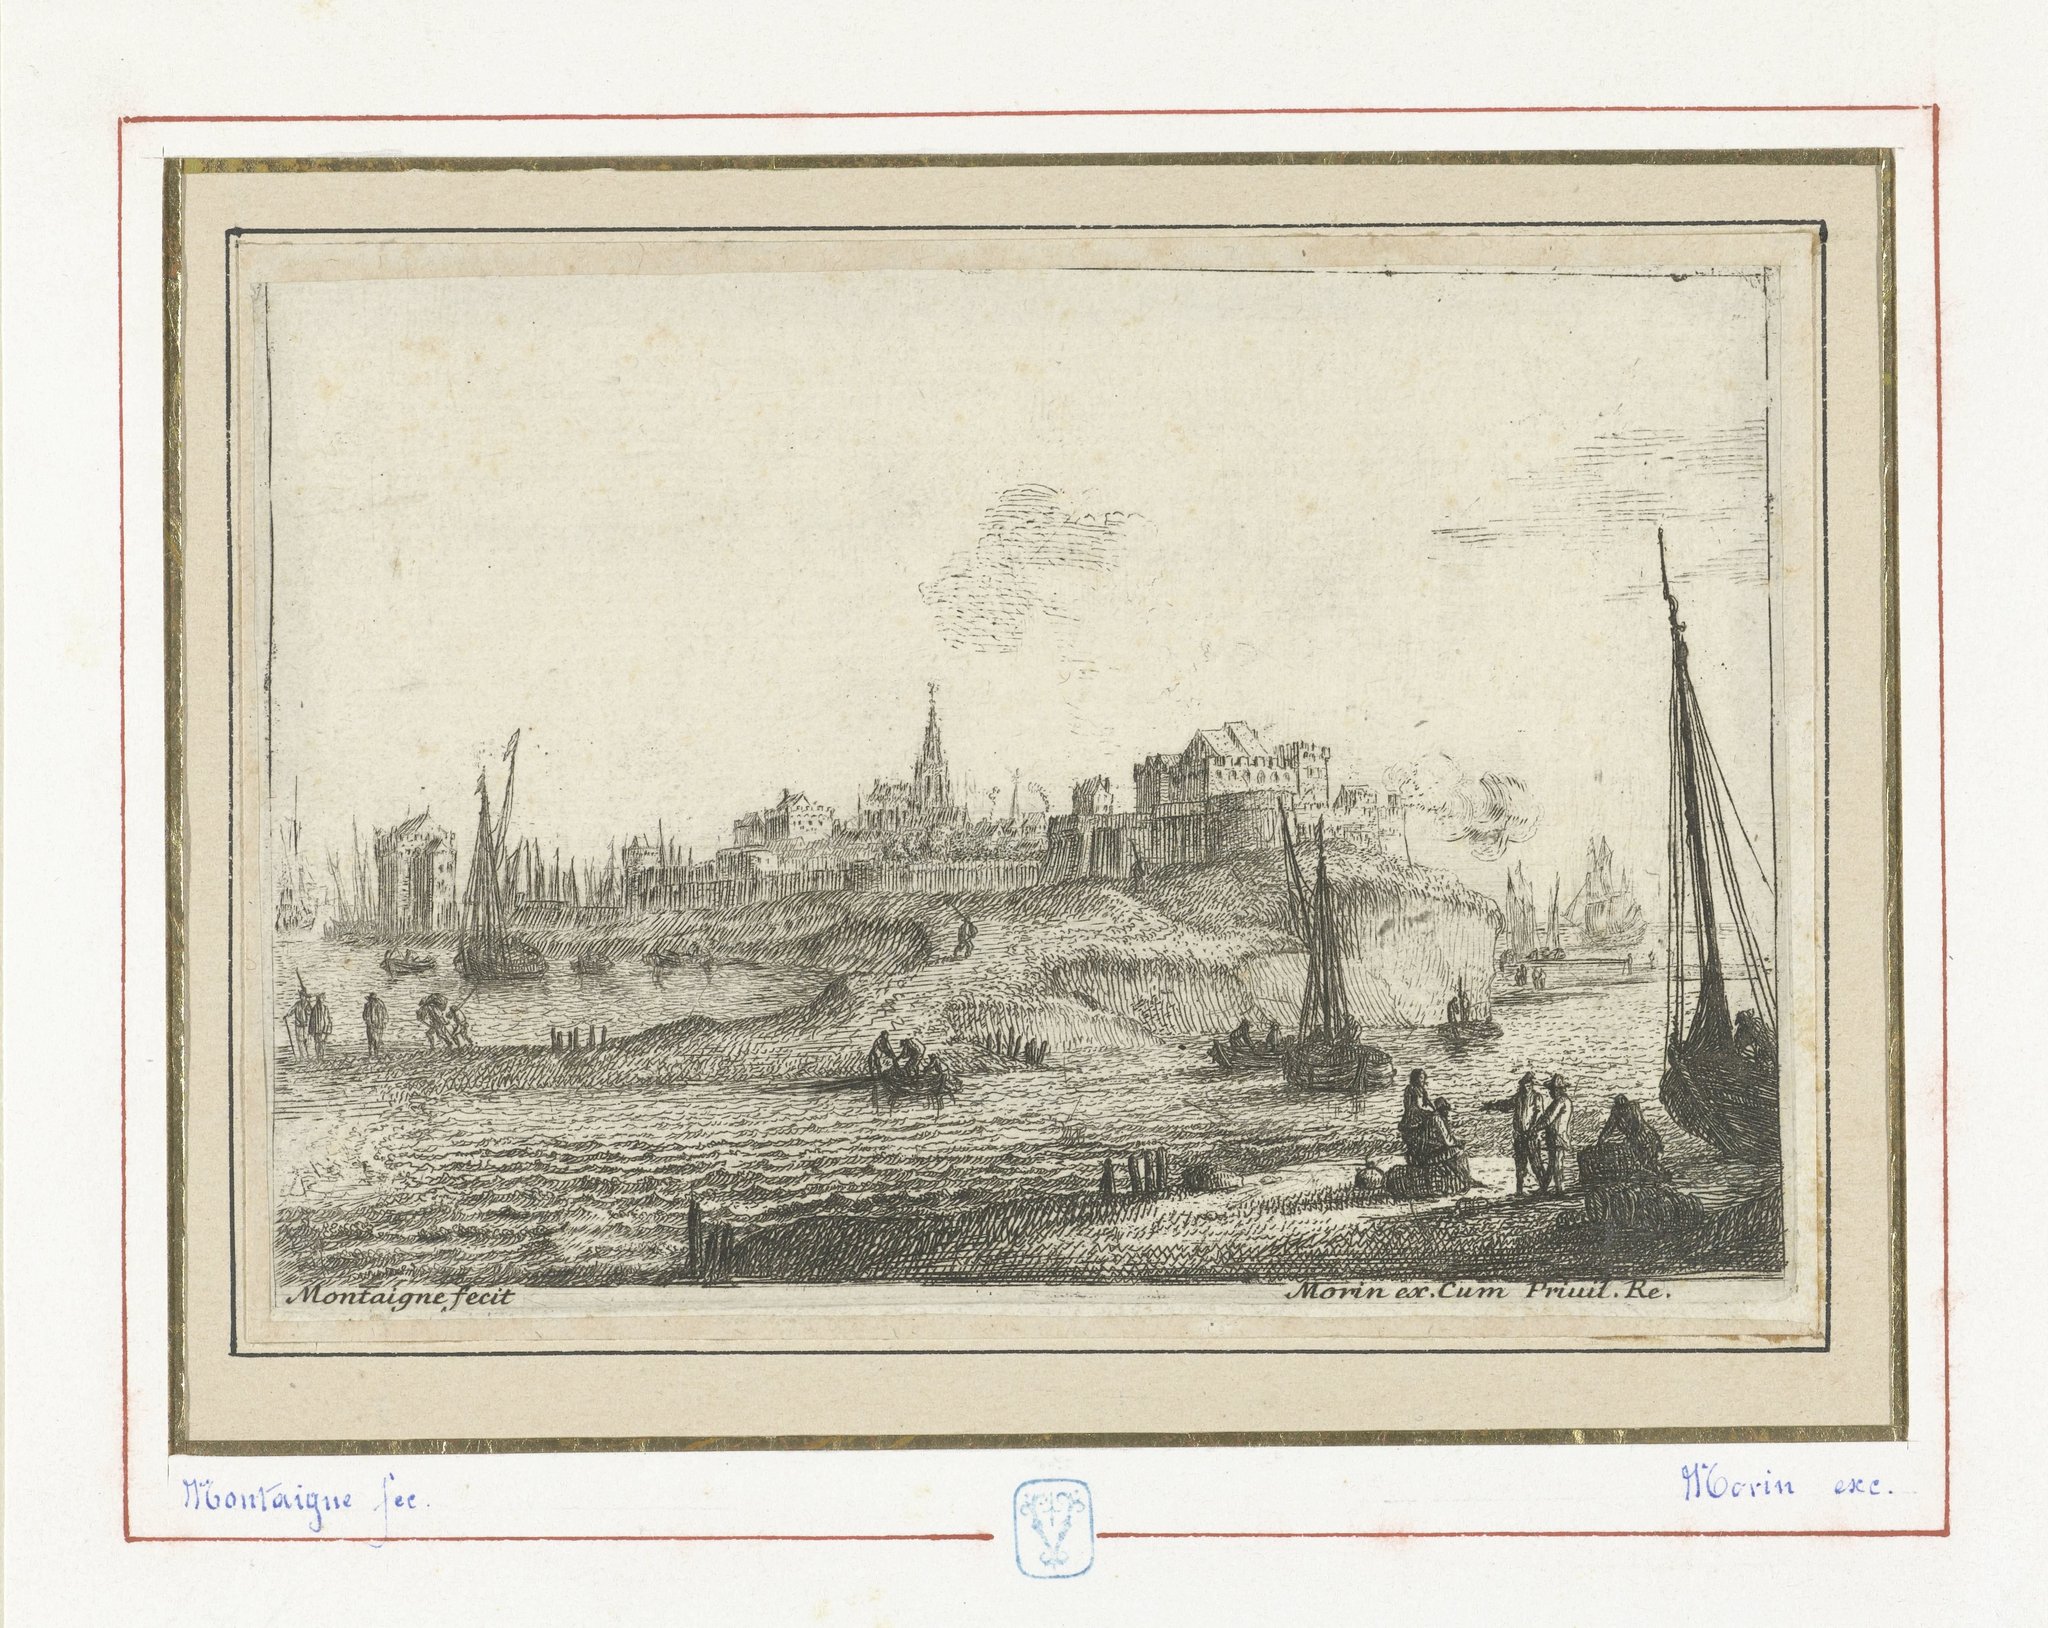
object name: print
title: Stad op schiereiland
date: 1617-1660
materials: paper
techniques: engraving, etching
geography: paris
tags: harbour, peninsula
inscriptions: collector's mark: Lugt 2228, collector's mark: Lugt 2498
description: Gezicht op een stad op een schiereiland. Links een haven. Op de voorgrond een pier.